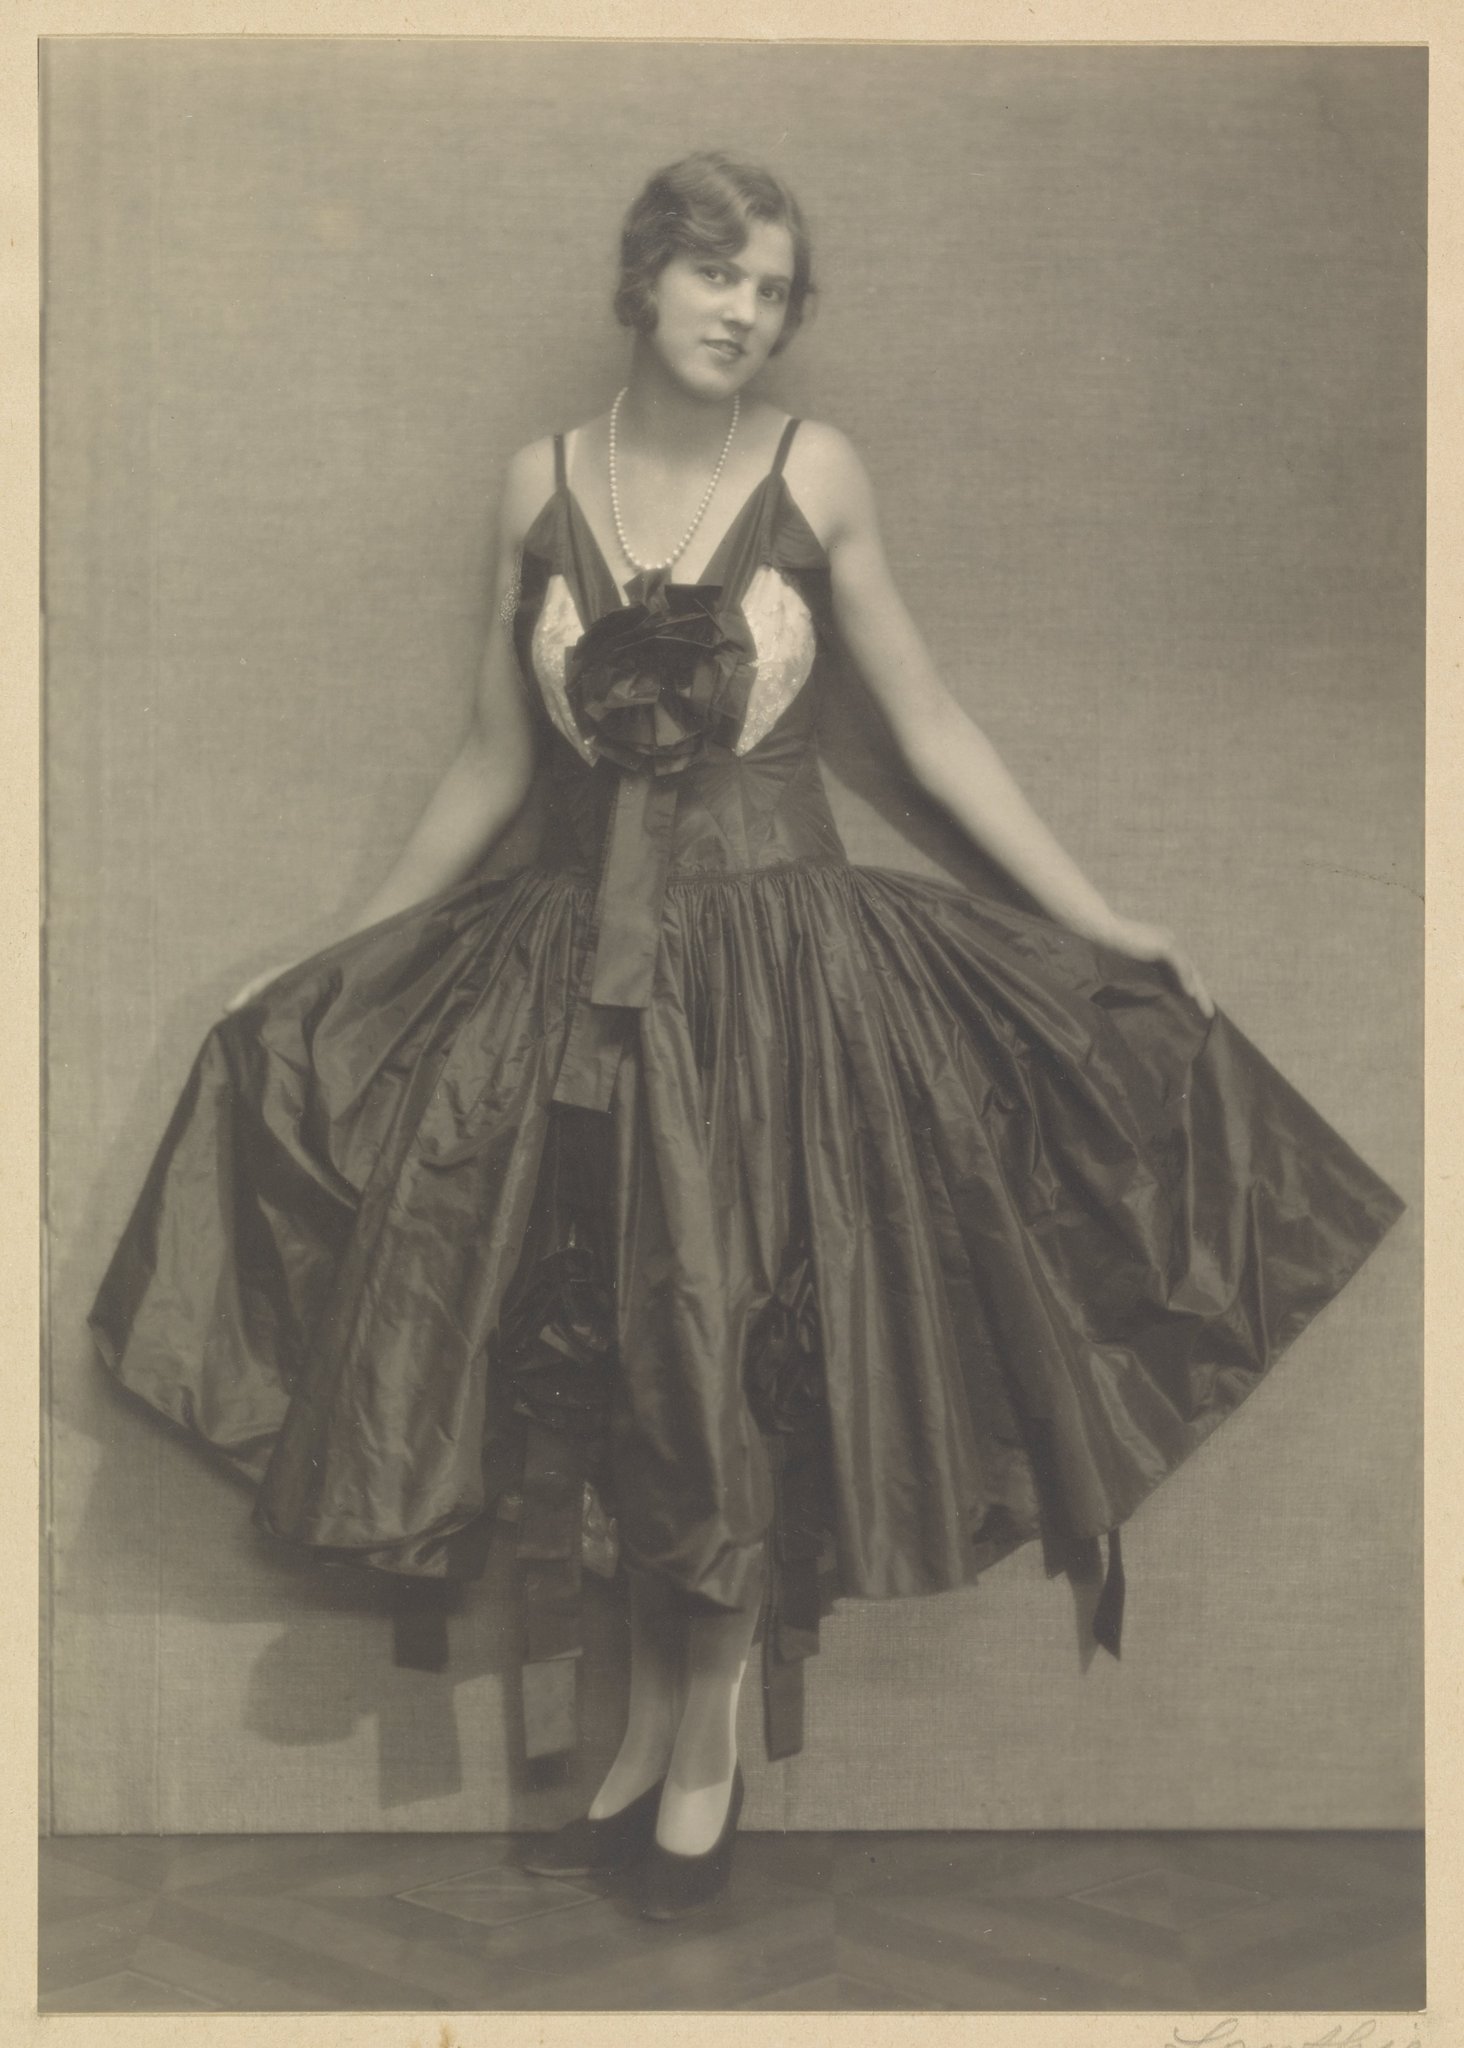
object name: photograph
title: Studio Potraits of Germaine Urtebise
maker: rené lonthie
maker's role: fotograaf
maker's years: 1889-1959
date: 1920-1925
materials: paper, photographic support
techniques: gelatin silver print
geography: belgium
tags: amsterdam, model, mannequin, dress, gown, necklace (+ women's clothes), belgium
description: These photographs were part of a portfolio Mrs Brusse-Urtebise put together for her career in modelling. She wears a dress with a full skirt, known as a robe de style, which was fashionable in the 1920s. The fulllength photograph resembles Lonthie’s fashion shots. However, it is unclear whether this was one of them or a portrait photograph.